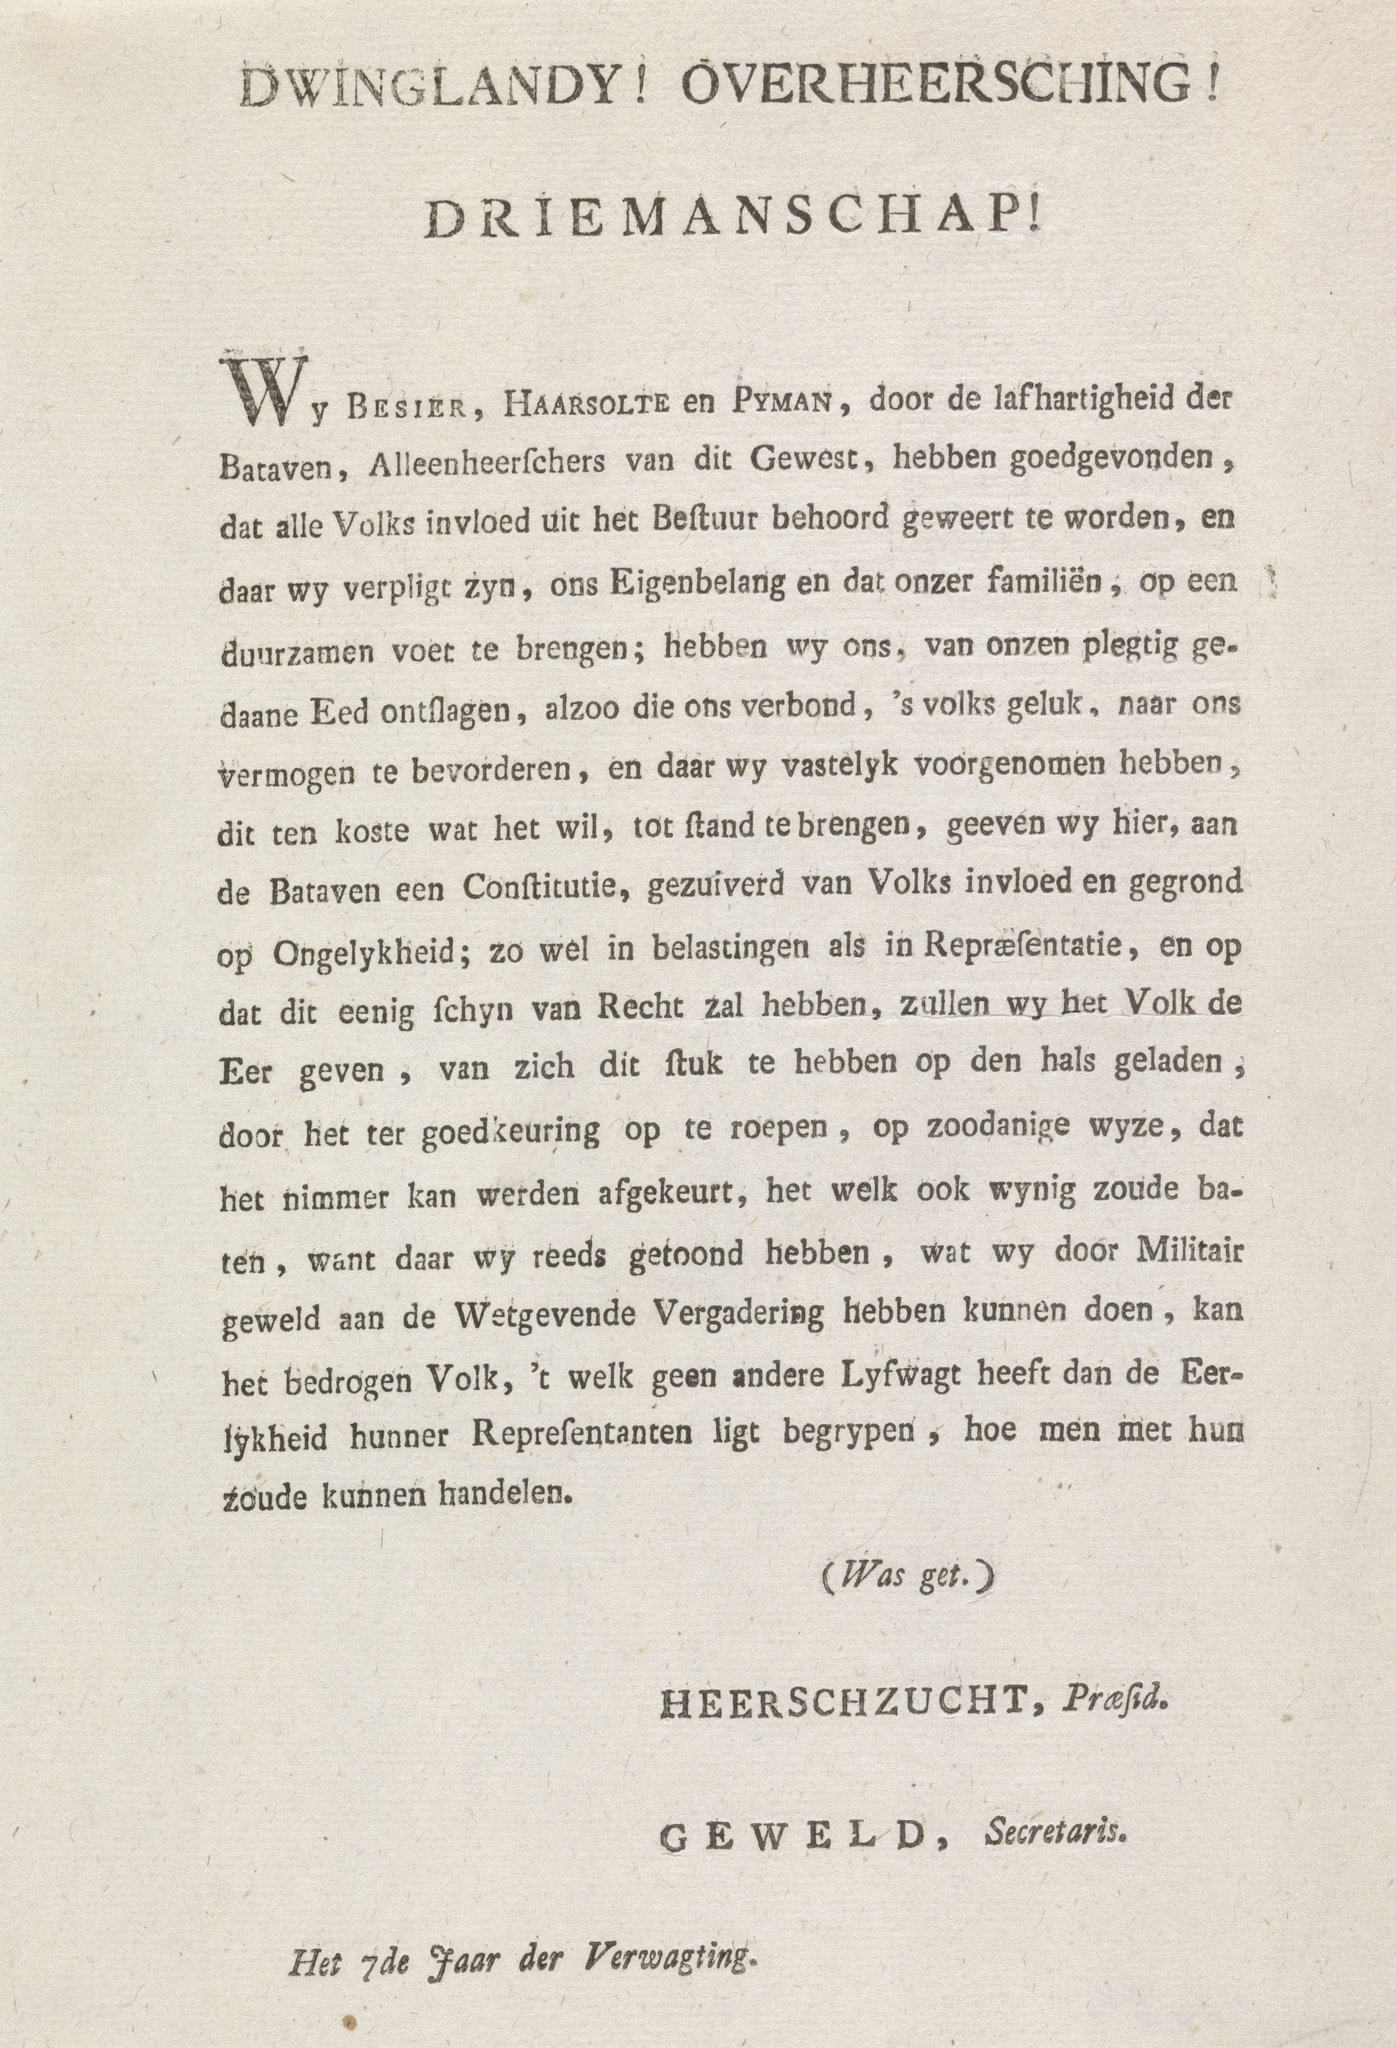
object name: text sheet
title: Dwinglandy! Overheersching! Driemanschap!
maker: Anonymous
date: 1801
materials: paper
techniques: letterpress printing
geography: netherlands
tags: utrecht, deventer, augustijn gerhard besier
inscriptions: collector's mark: Lugt 2228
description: Spotschrift op de proclamatie van het Uitvoerend Bewind met bekendmaking van de schorsing van het besluit door de Eerste Kamer van het Wetgevend Lichaam van 14 september 1801 waarin het volk werd opgeroepen ter goed- of afkeuring van het Ontwerp van Staatsregeling, 18 september 1801. Gericht tegen Besier, Haersolte en Pijman.